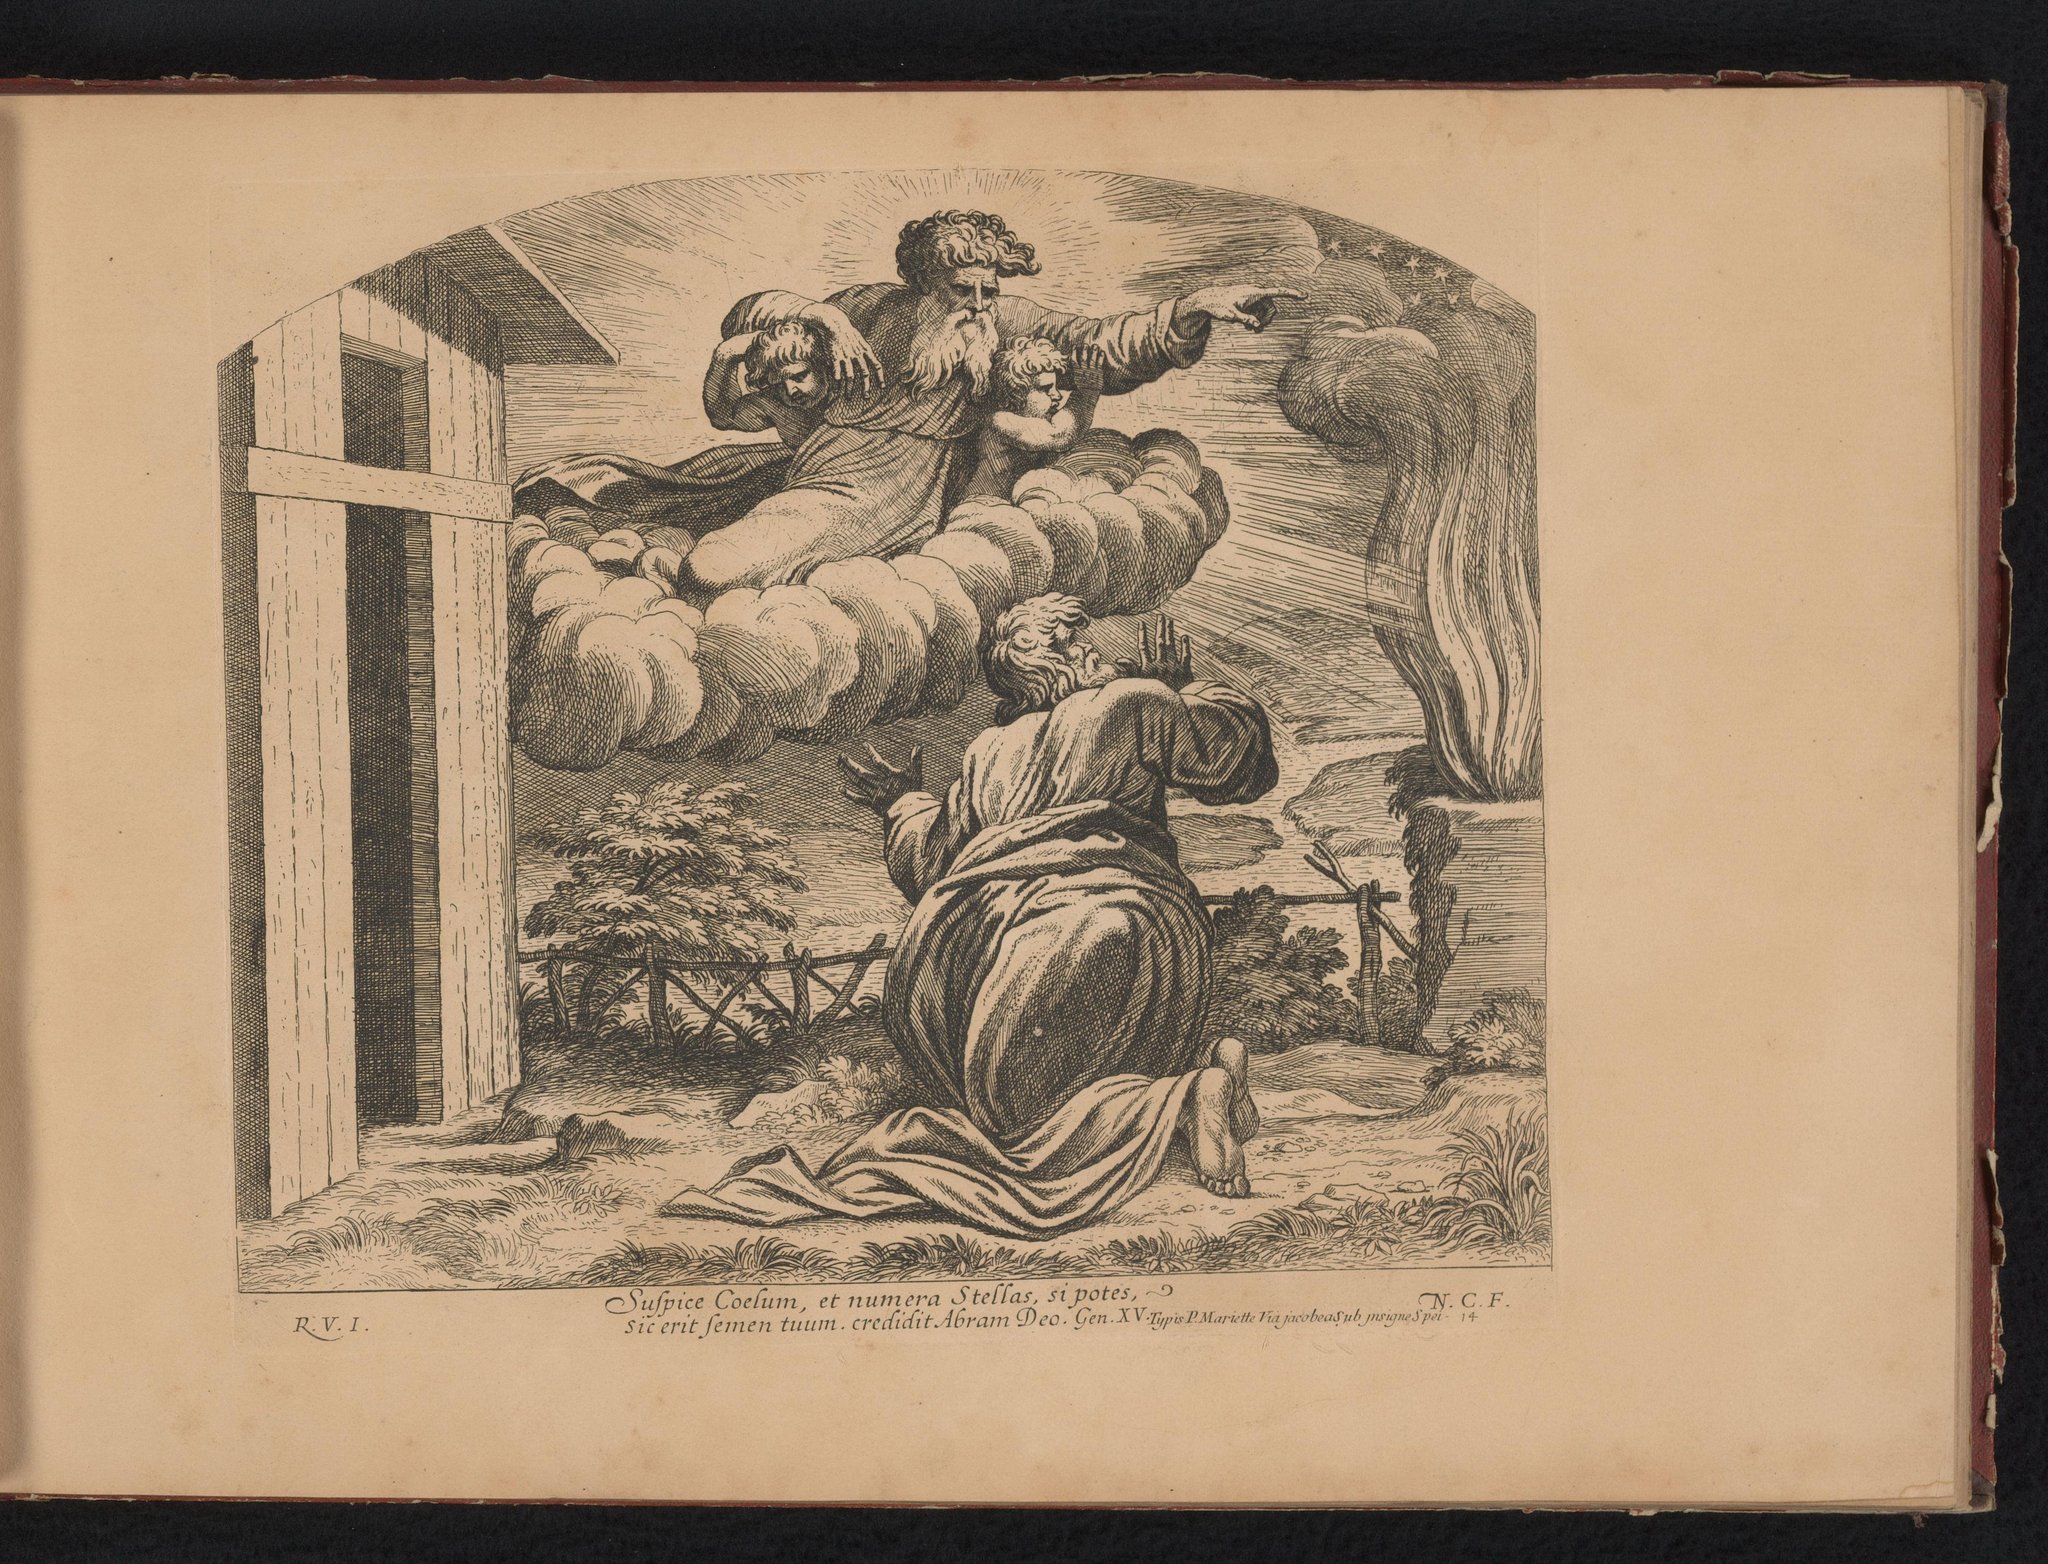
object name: album leaf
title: Abrahams ontmoeting met Melchisedek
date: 1649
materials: paper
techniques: etching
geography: paris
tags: the meeting of abraham and melchizedek, the high priest and king of salem, who brings bread and wine (genesis 14:18-20)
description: Deze prent maakt deel uit van een album.